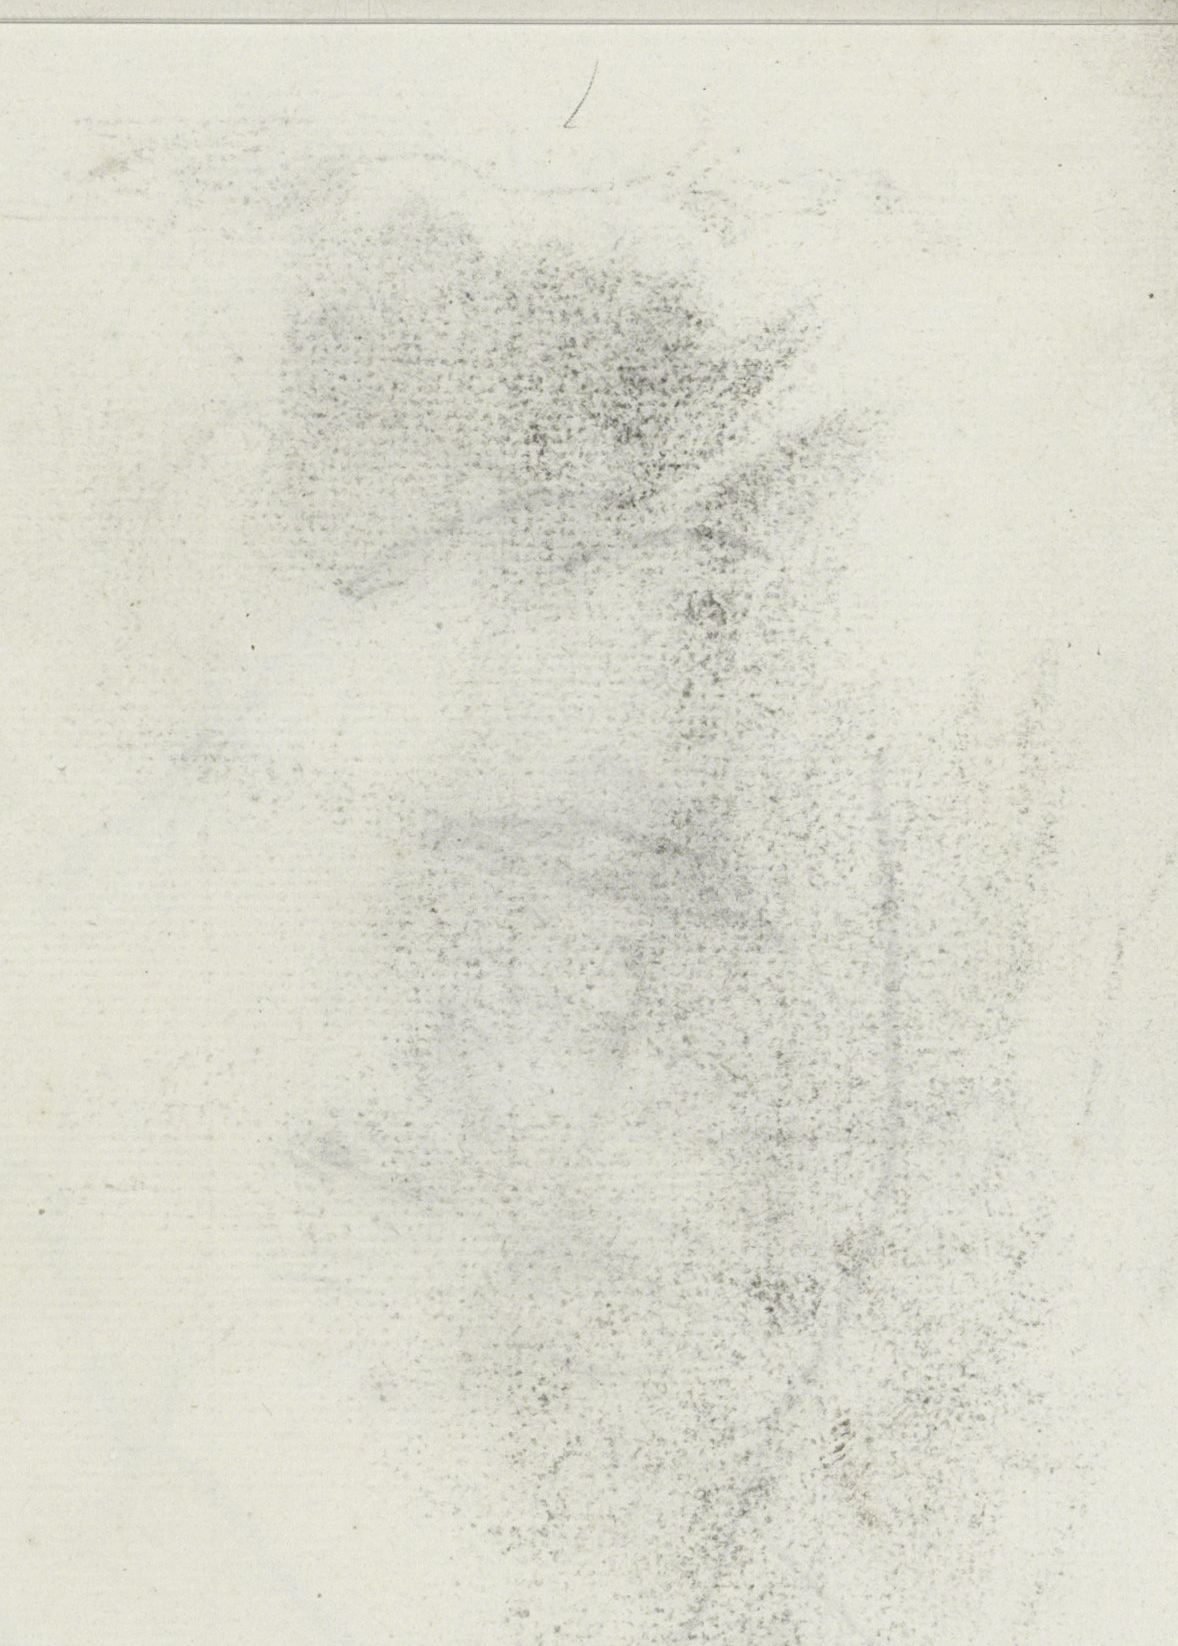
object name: sketchbook leaf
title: Abklatsch van de krijttekening op pagina 5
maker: isaac israels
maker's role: draughtsman, painter, print maker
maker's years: 1865-1934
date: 1886-1903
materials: paper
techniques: printmaking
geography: amsterdam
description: Pagina 6 uit schetsboek XXXVII met 52 pagina's.